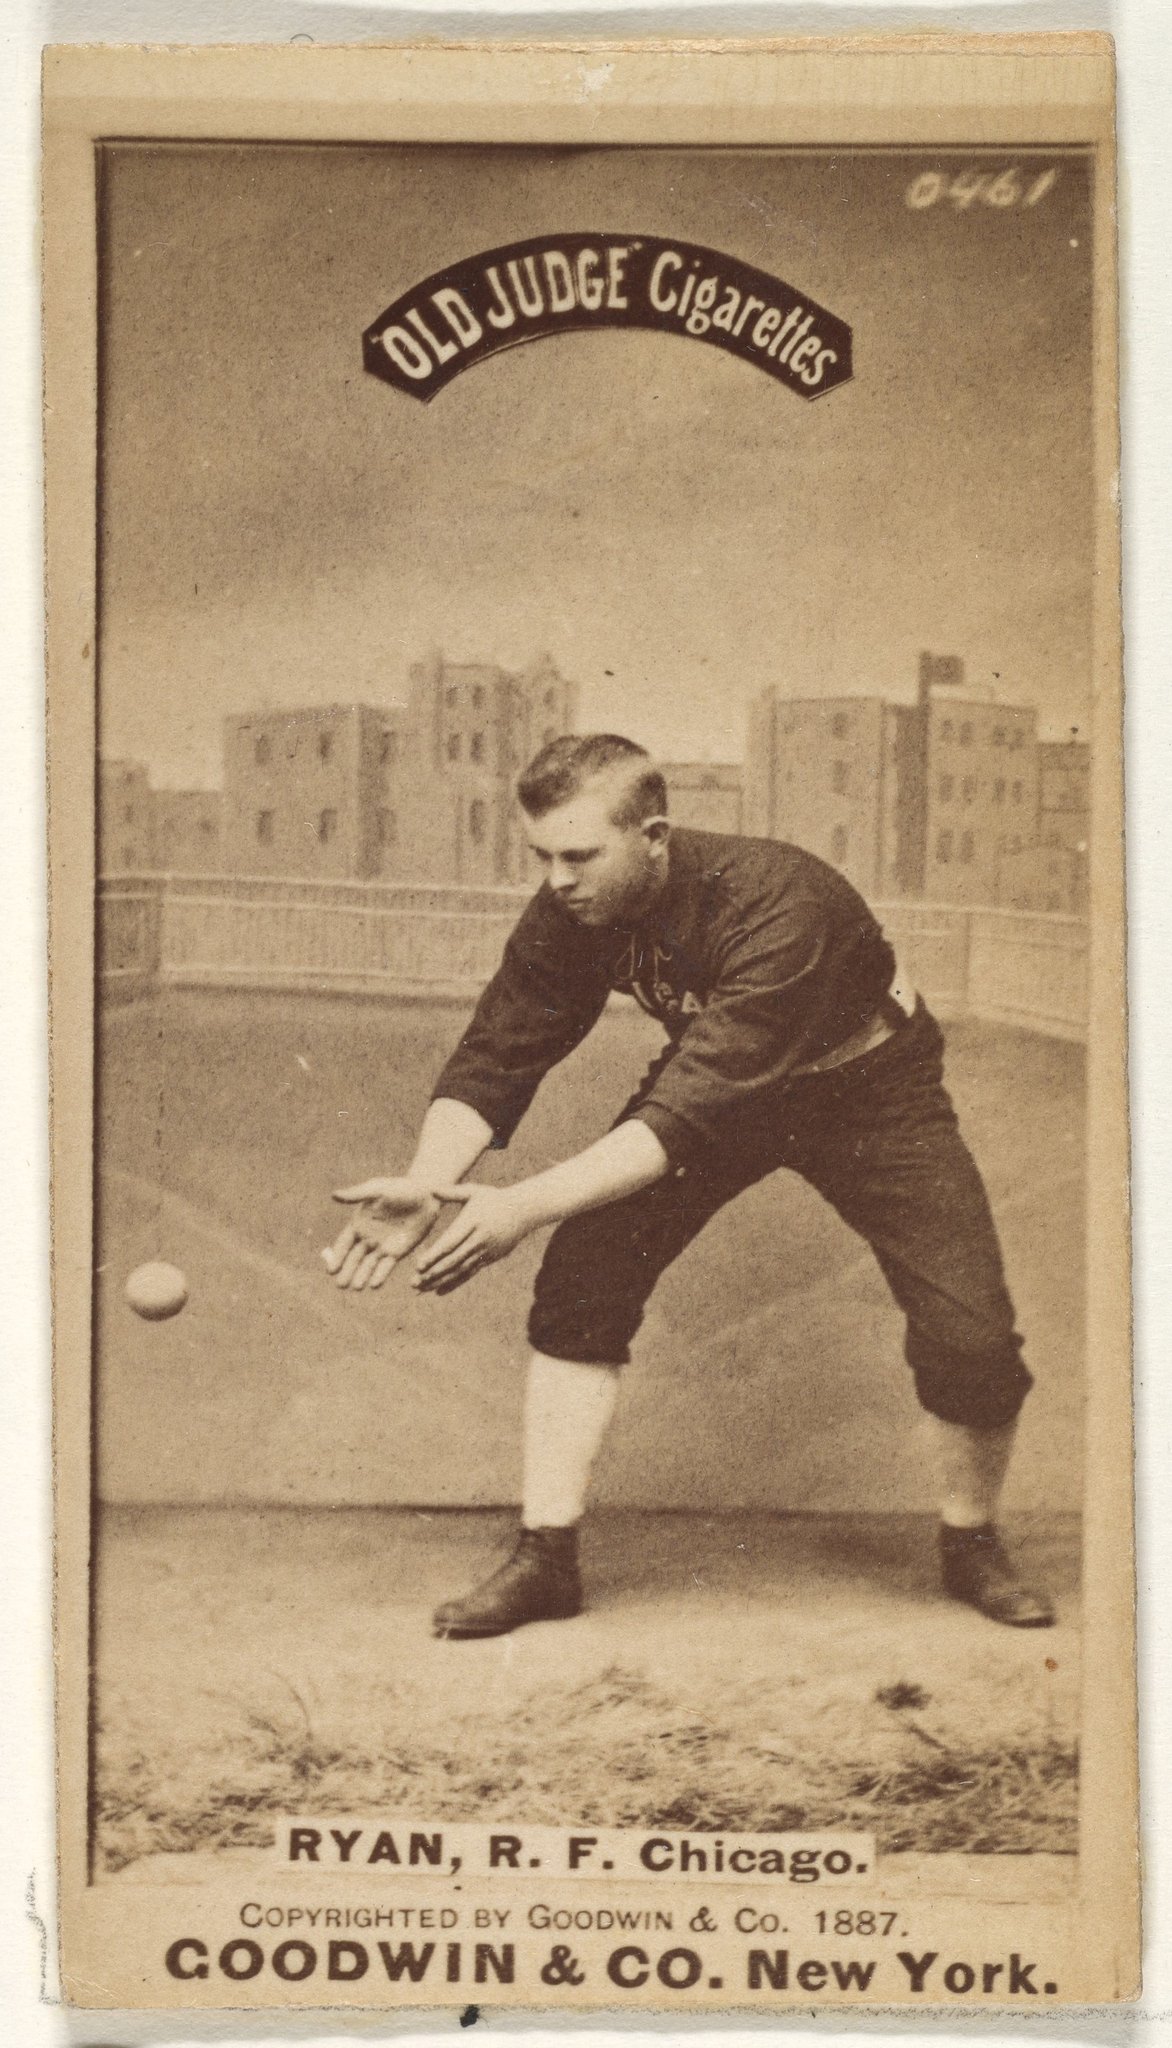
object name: baseball card, photograph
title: Ryan, Right Field, Chicago, from the Old Judge series (N172) for Old Judge Cigarettes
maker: goodwin & company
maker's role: publisher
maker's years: 1850-1950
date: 1887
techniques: albumen silver print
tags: men,portraits,baseball,athletes